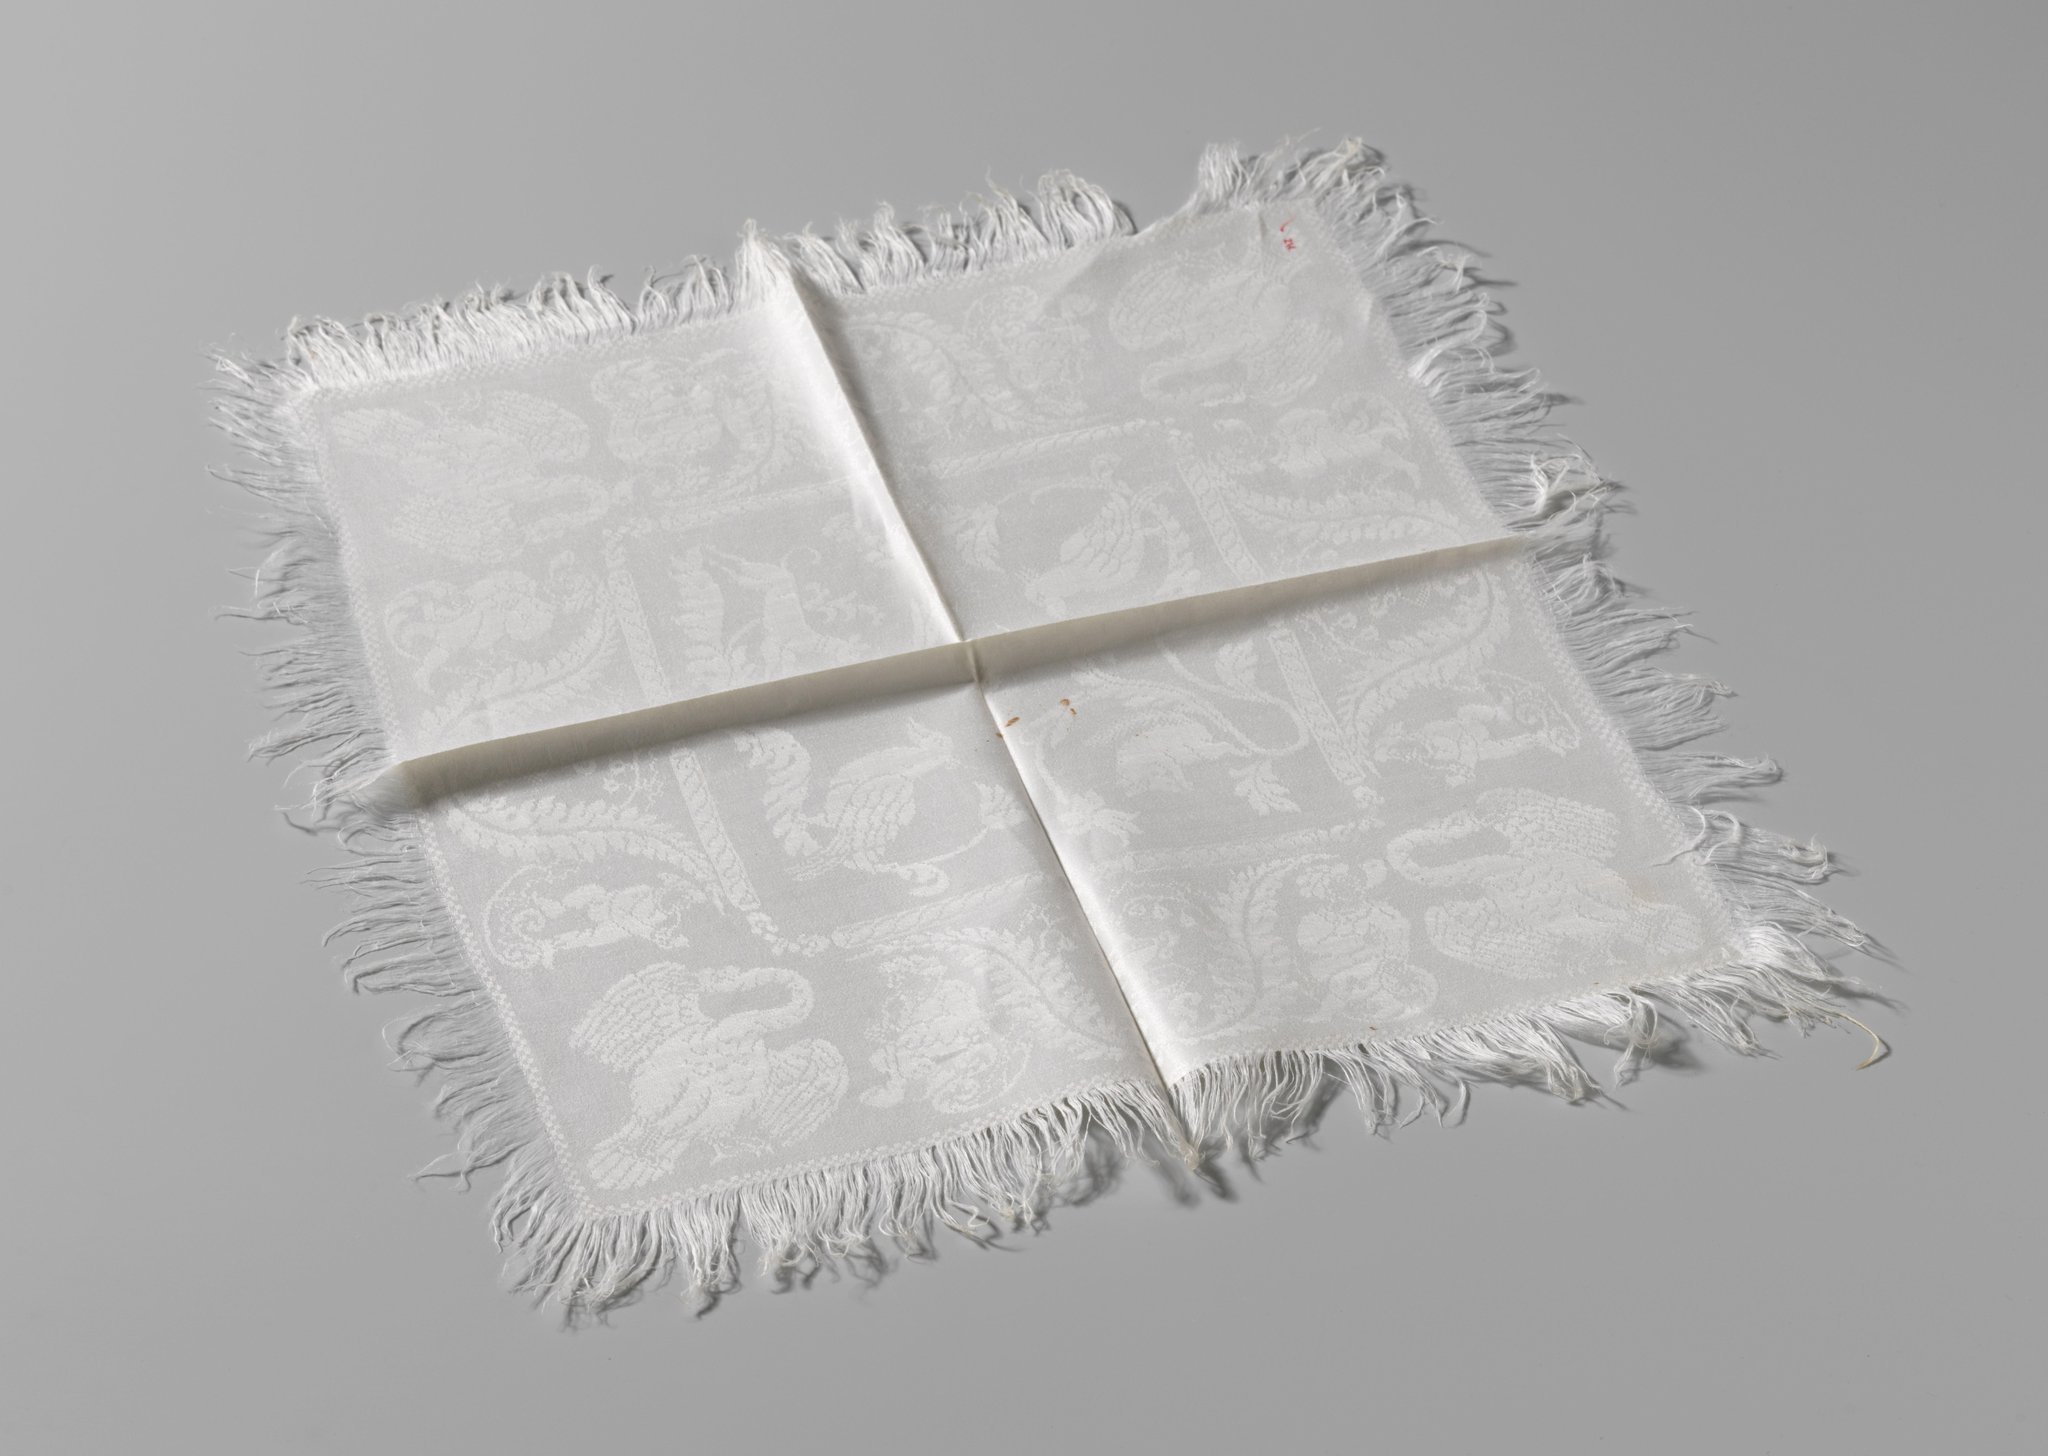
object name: vingerdoek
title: Pijprokende Turken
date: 1850-1899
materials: linen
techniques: damask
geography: veghel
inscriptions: mark: ‘ZK’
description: Vingerdoek van wit linnendamast, met dessin van pijprokende Turken.